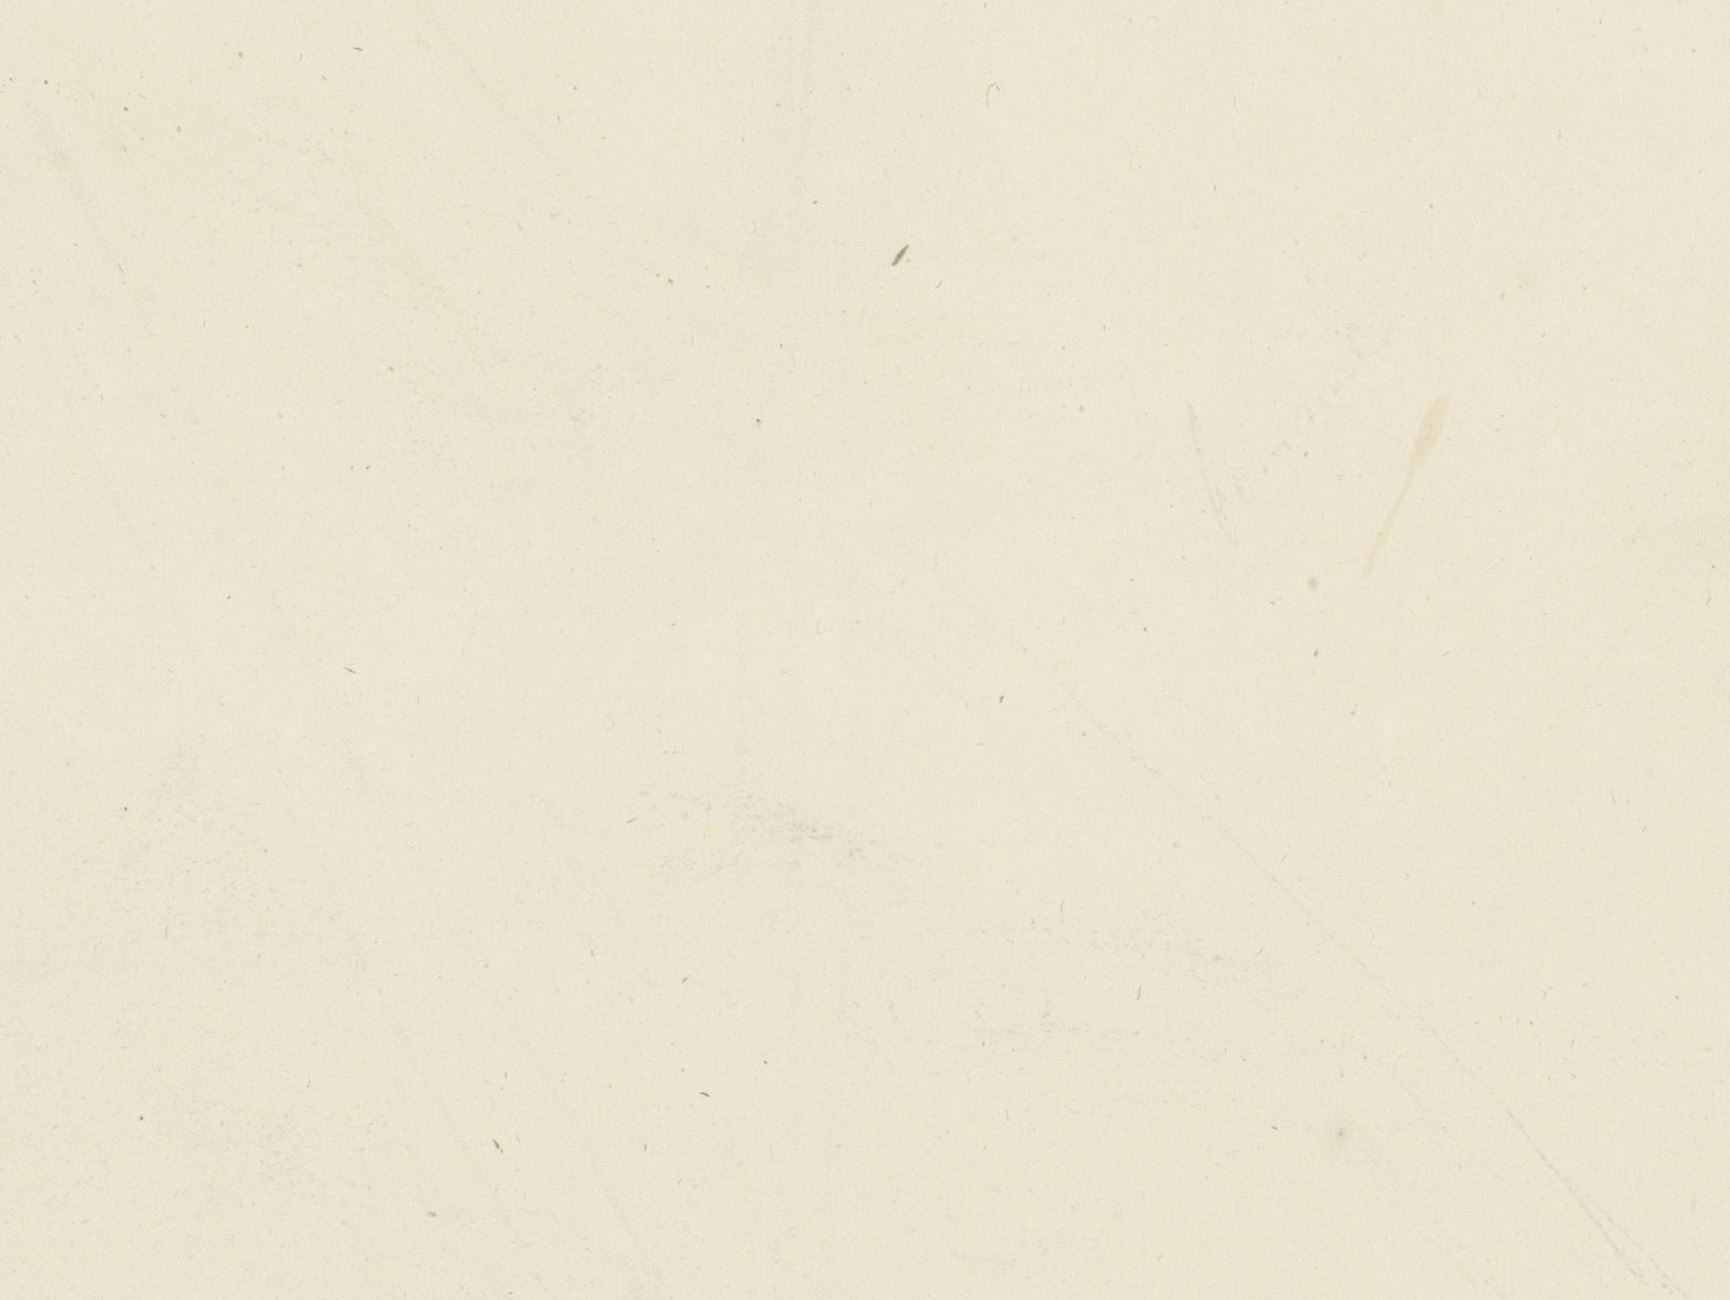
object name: sketchbook leaf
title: Studie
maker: petrus johannes schotel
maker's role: draughtsman, painter, print maker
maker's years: 1808-1865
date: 1825-1875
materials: paper, pencil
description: Mogelijk een onderdeel van een schip. Blad 18 verso uit een schetsboek met 44 bladen.